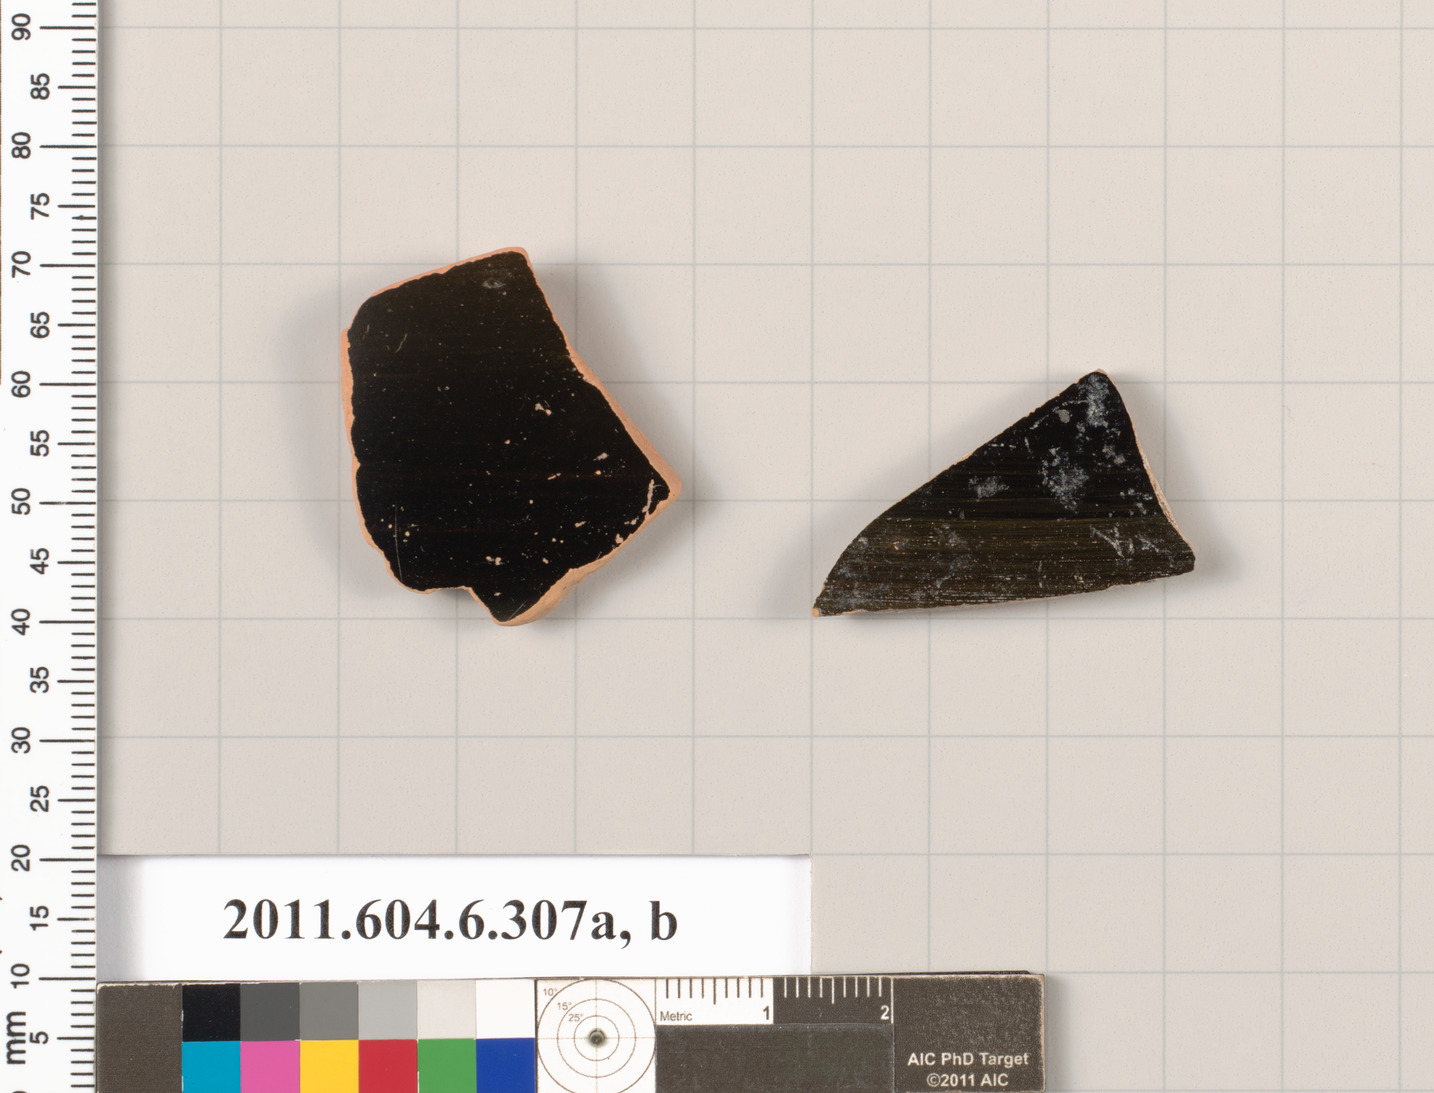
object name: undetermined open shape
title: Terracotta fragments of open shapes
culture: greek, attic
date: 600-401 BCE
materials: terracotta